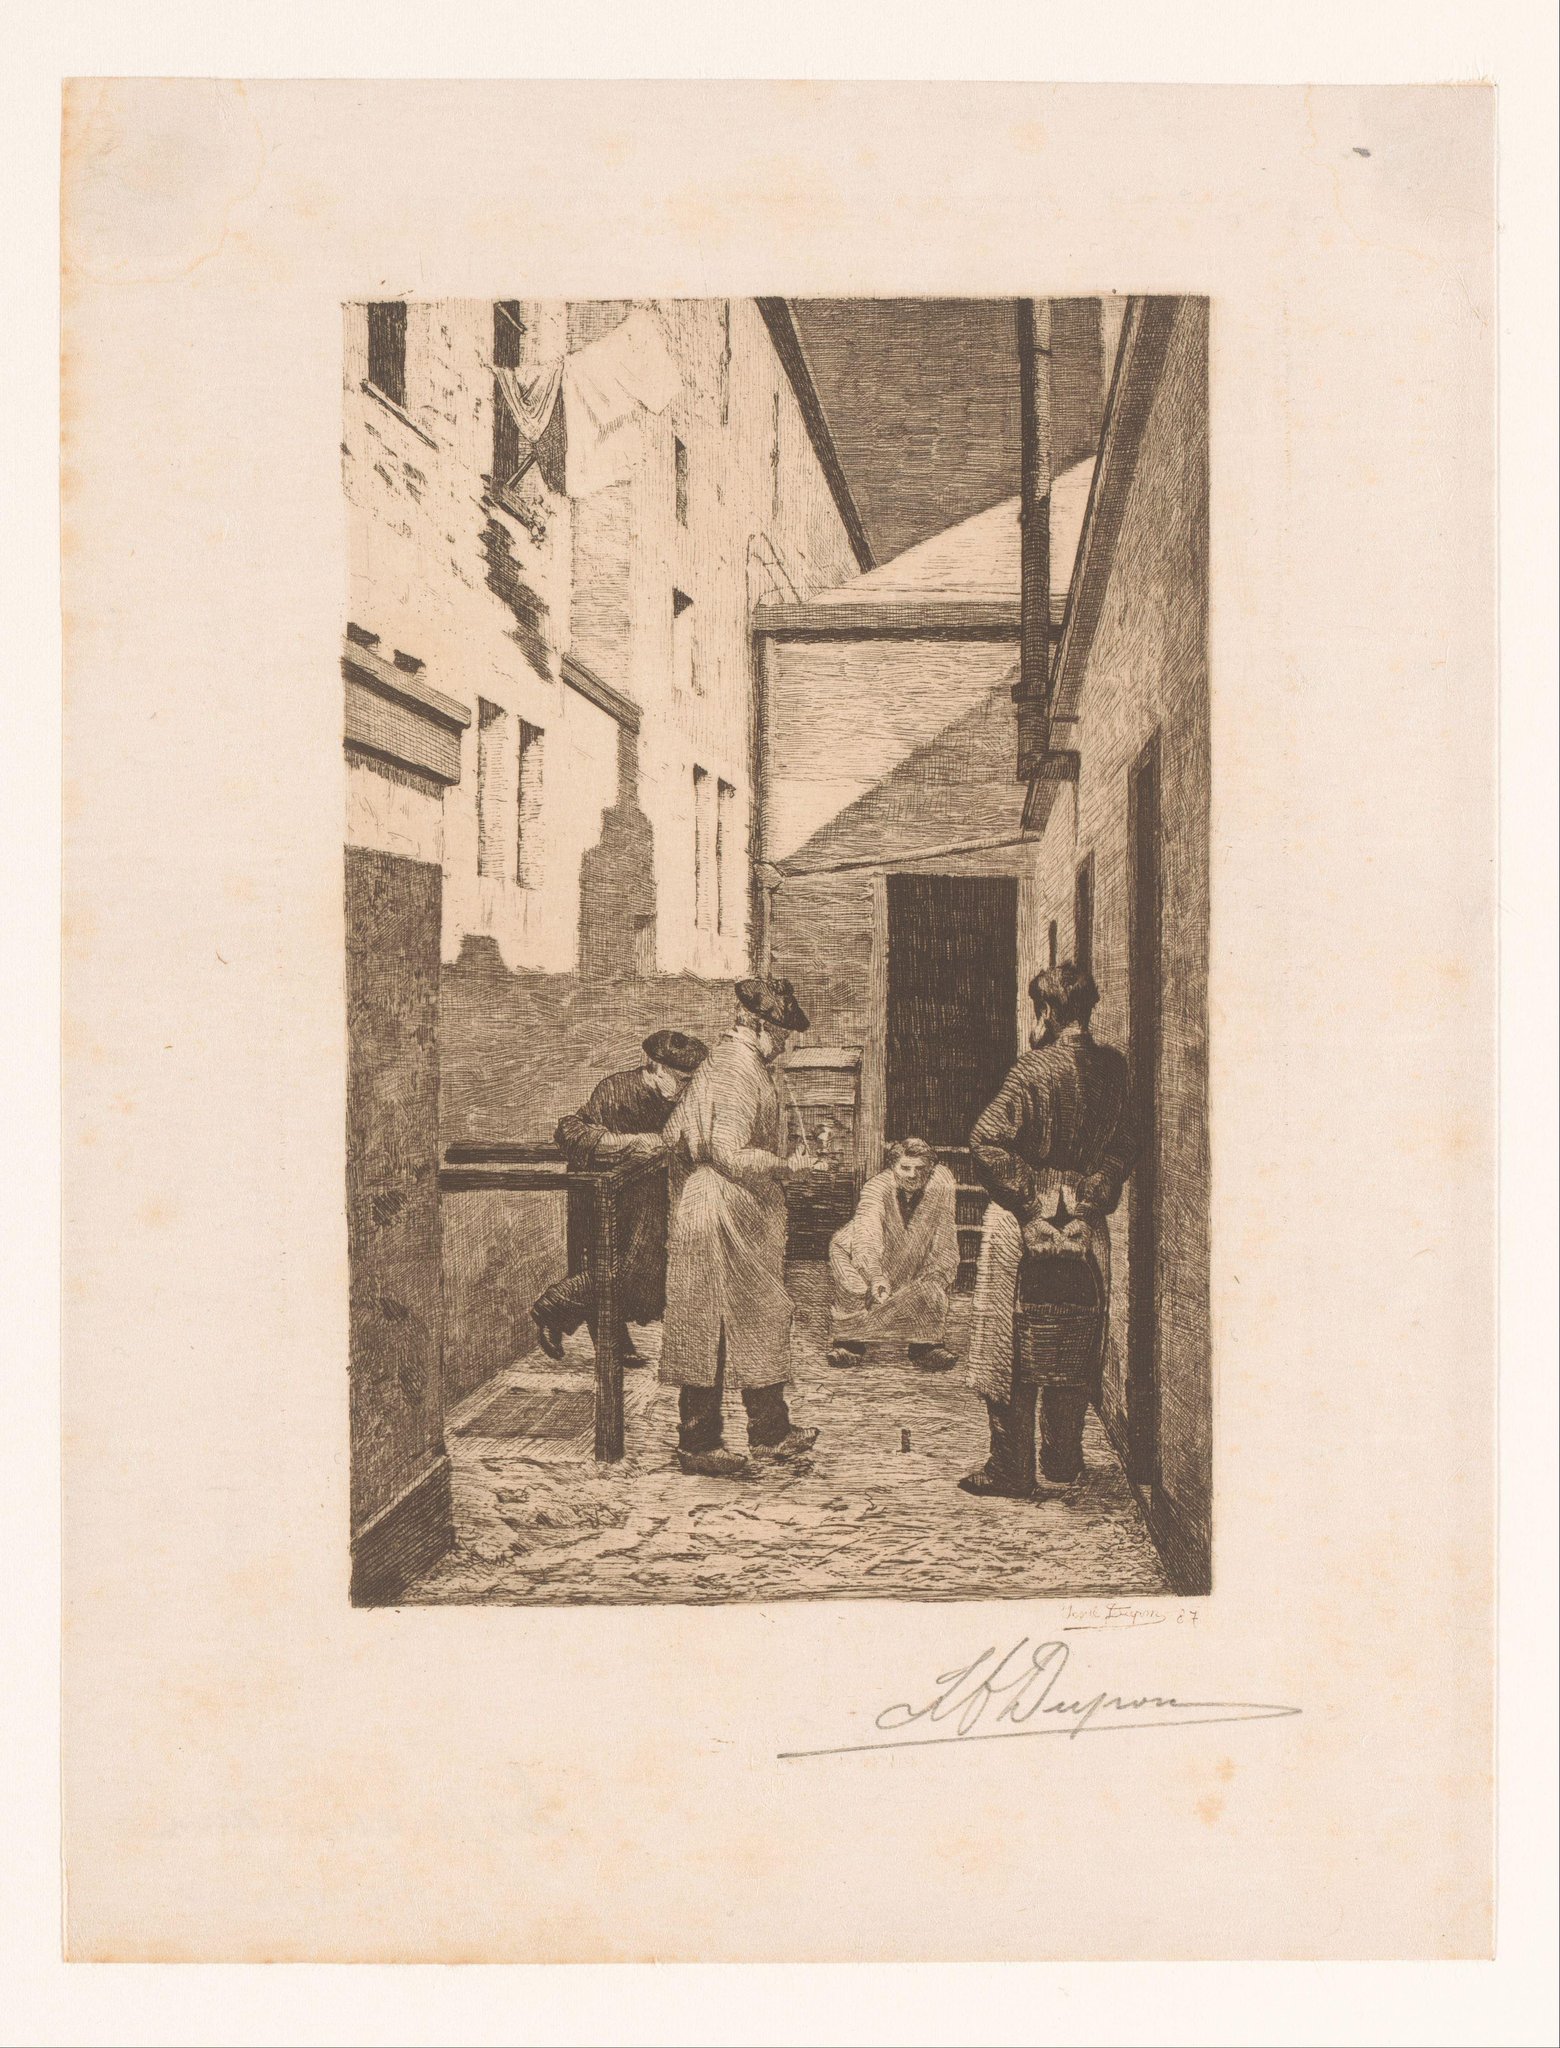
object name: print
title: Vier figuren spelen een spel met kurken in een steeg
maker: josué dupon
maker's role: print maker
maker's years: 1864-1935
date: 1887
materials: paper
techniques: etching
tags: children's games and plays, lane, alley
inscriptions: mark: ‘Antwerpsche Etsers 1880’, collector's mark: Lugt 2228